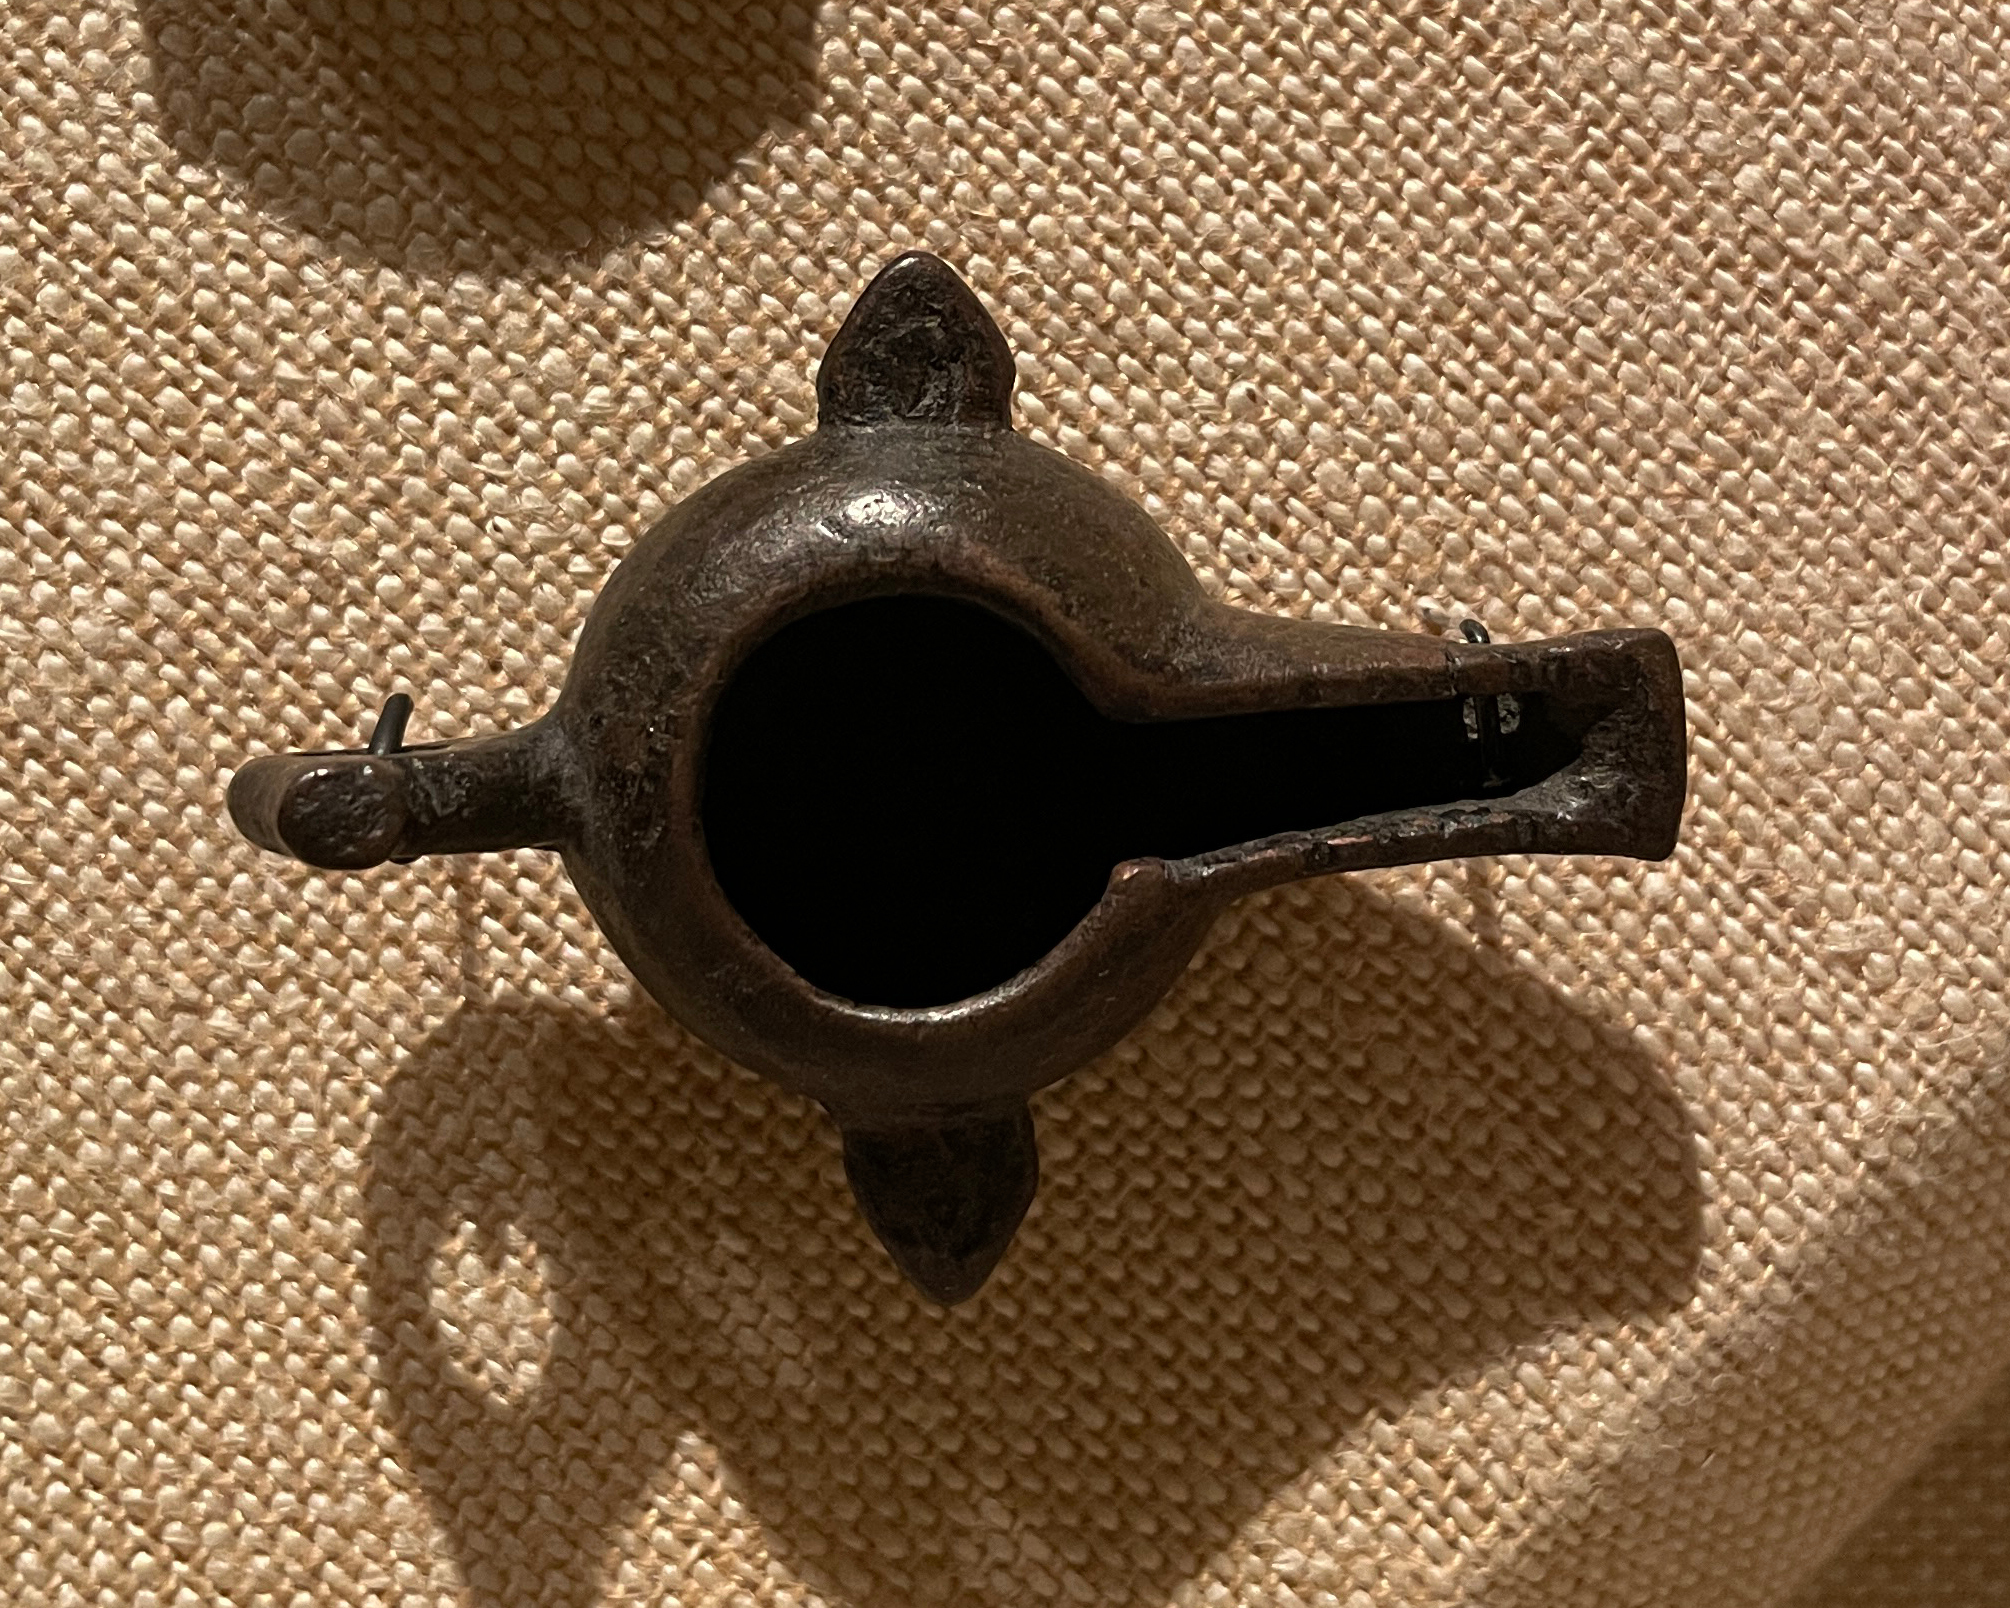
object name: lamp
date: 901-1100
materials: bronze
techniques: casting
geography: iran